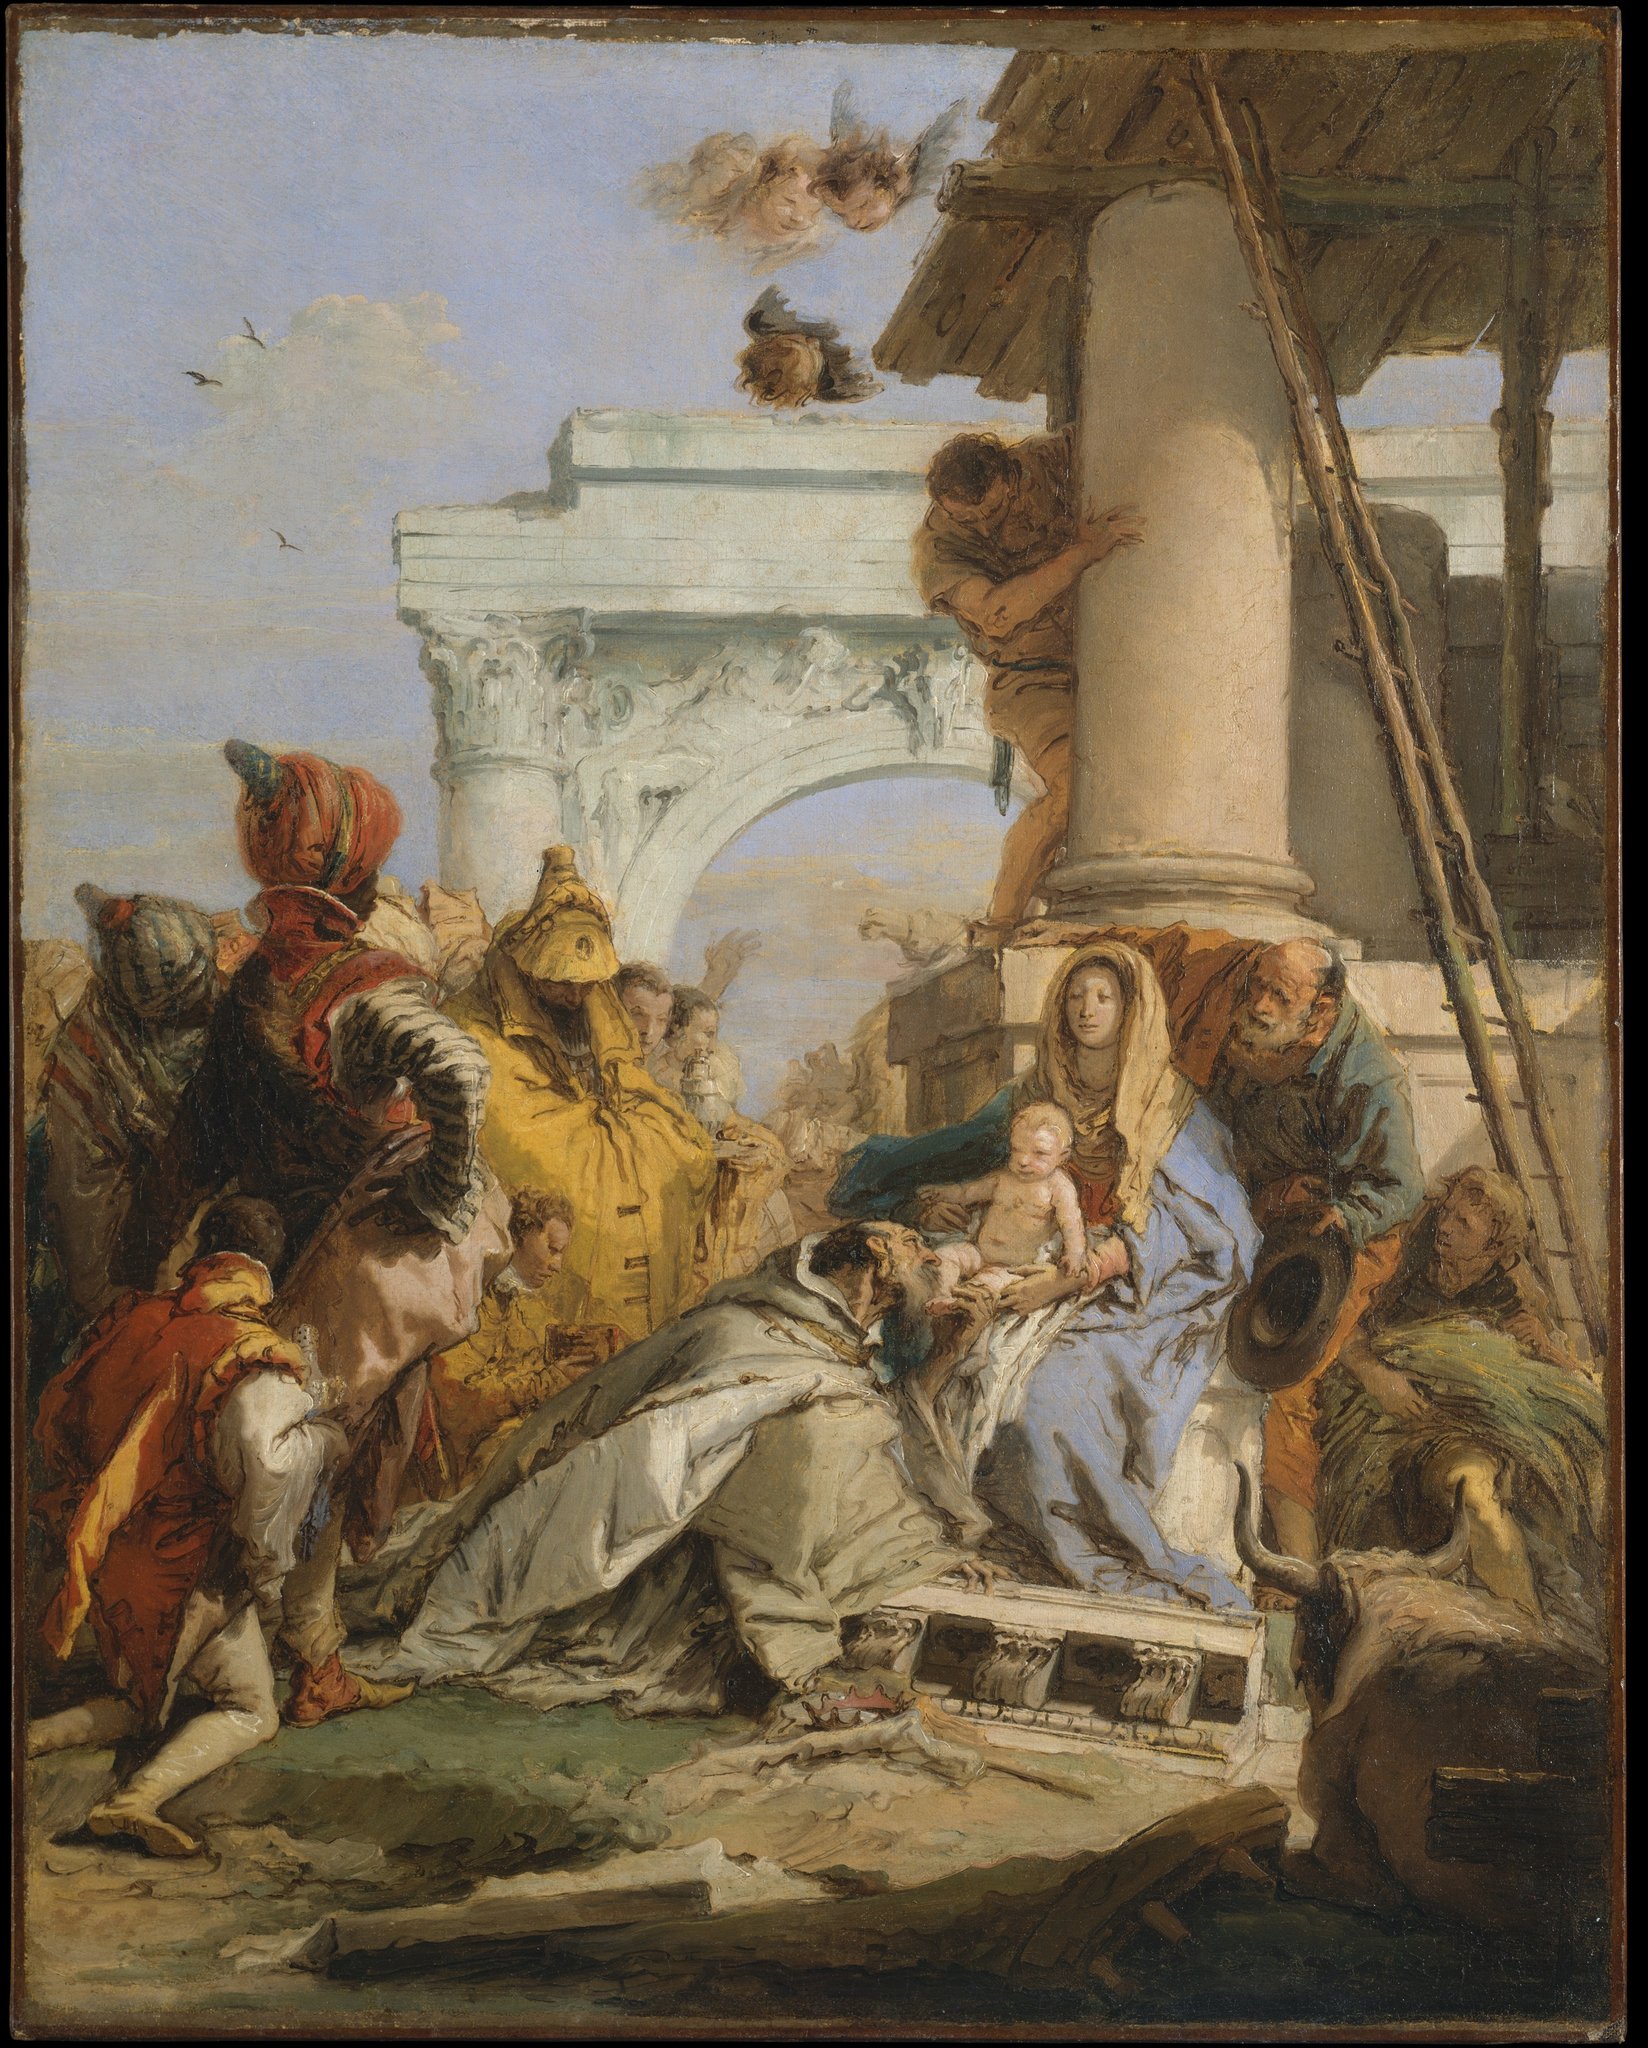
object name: painting, sketch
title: The Adoration of the Magi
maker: giovanni battista tiepolo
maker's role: artist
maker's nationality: italian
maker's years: 1696-1770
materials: canvas, oil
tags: angels,madonna and child,adoration of the magi